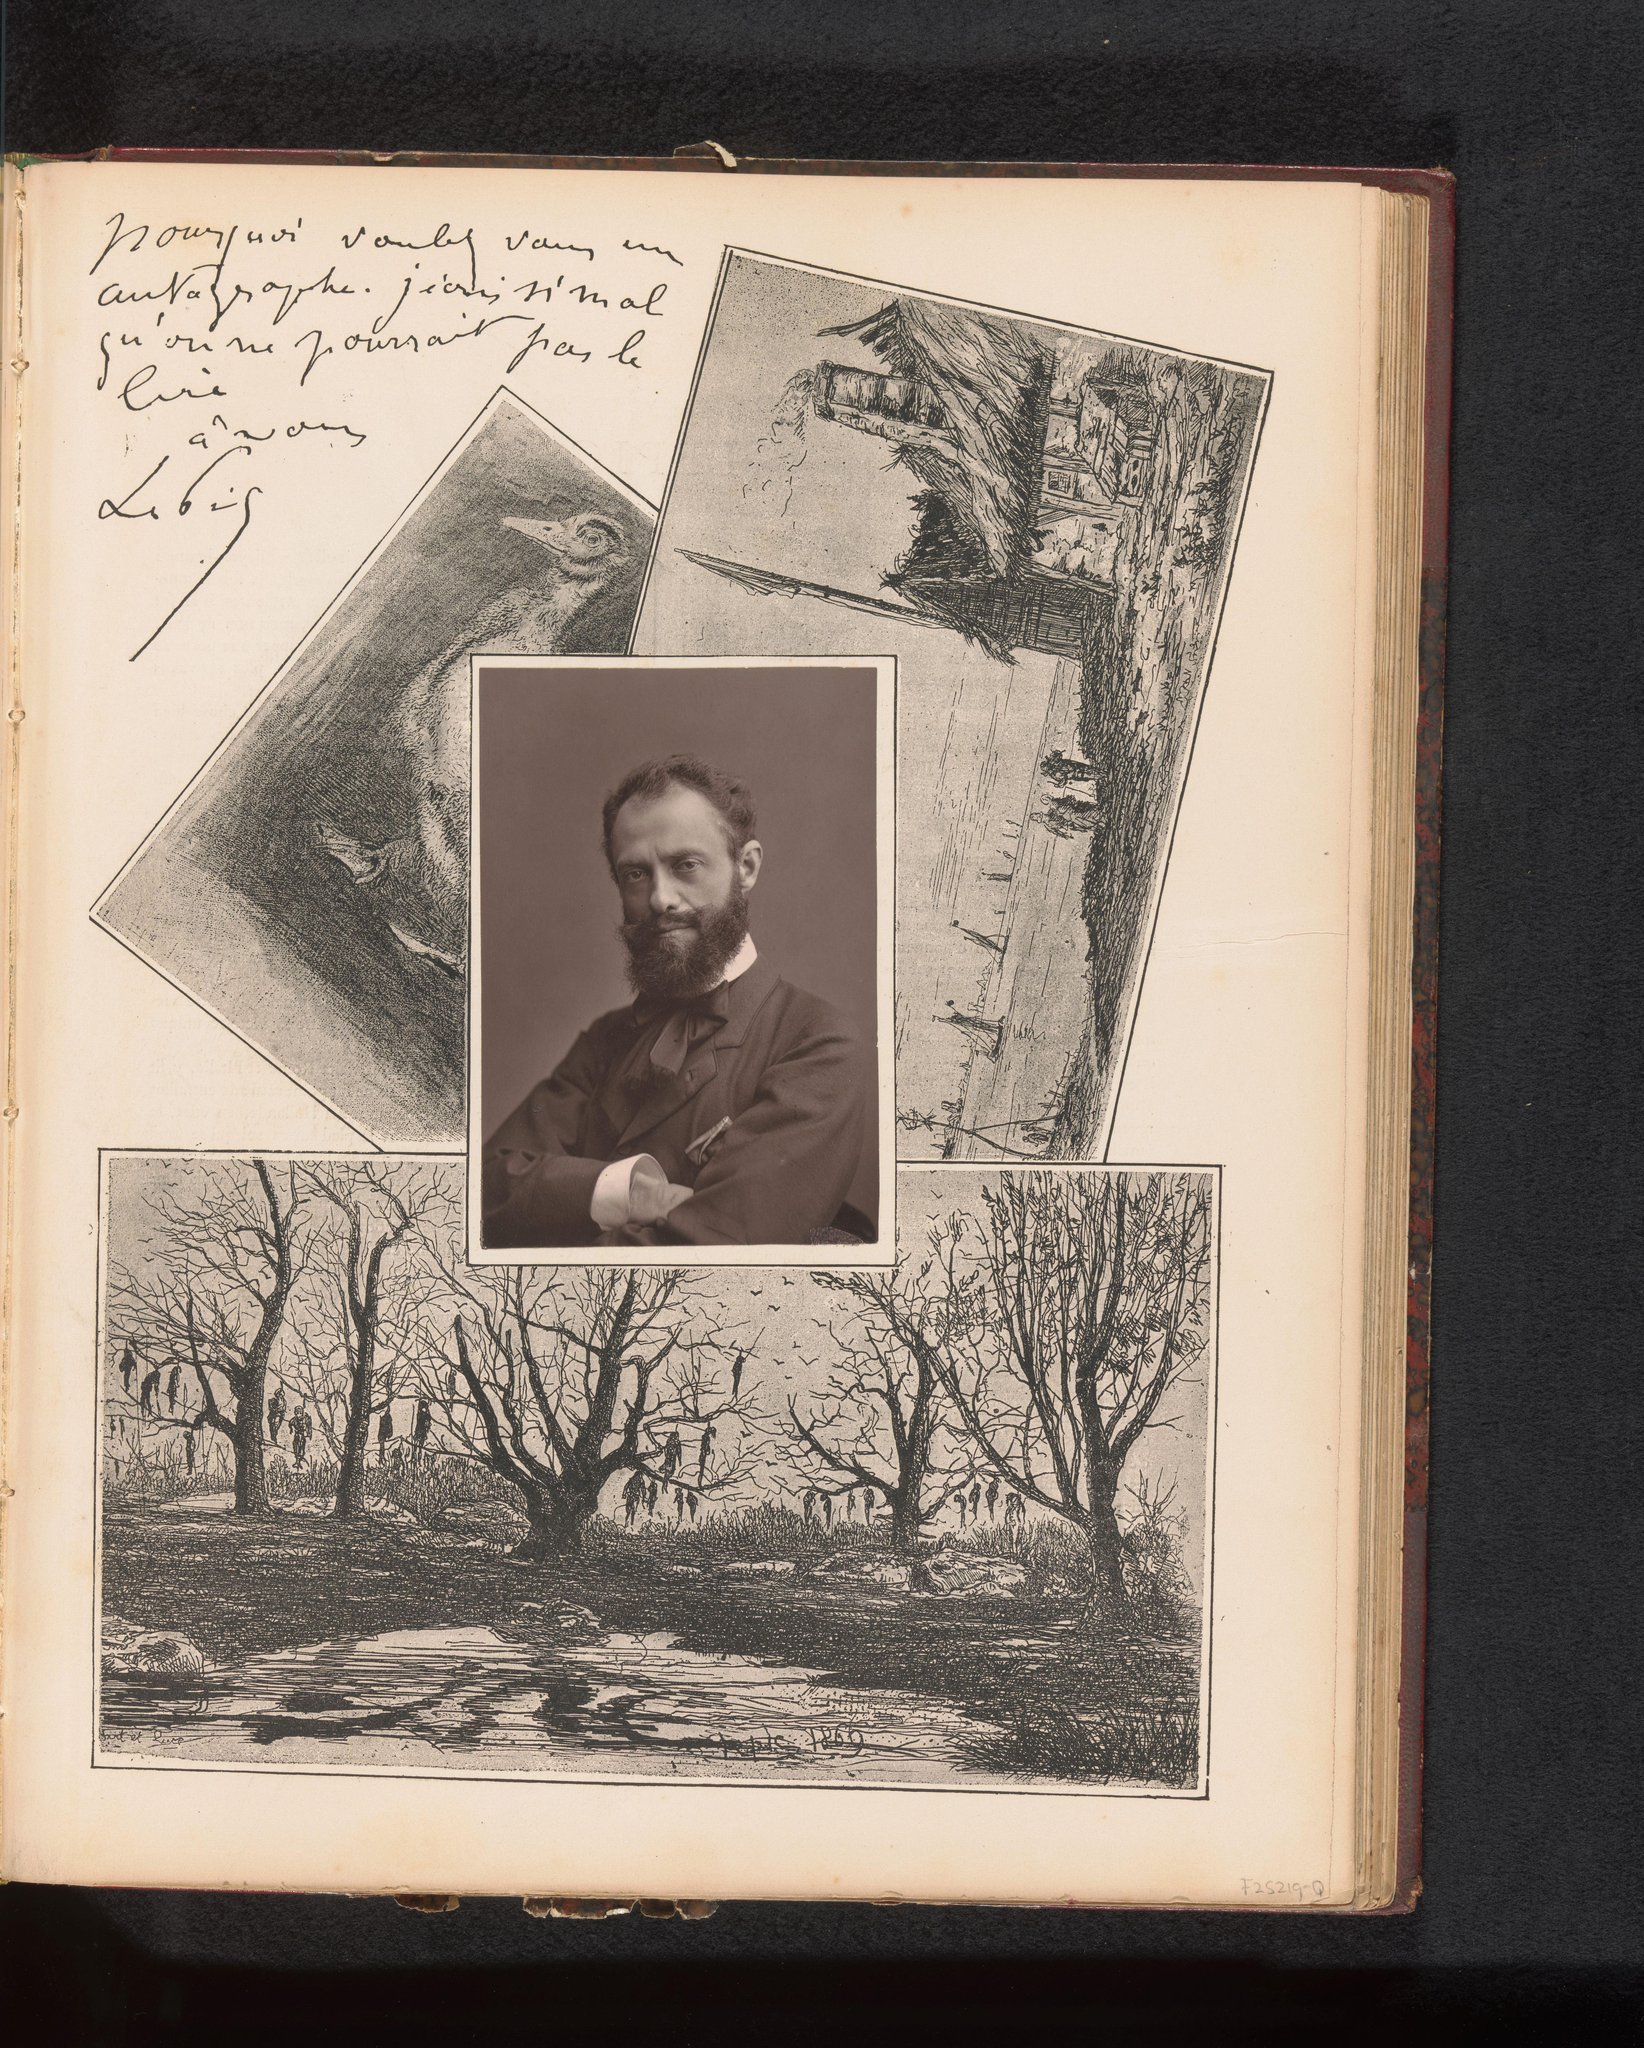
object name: photomechanical print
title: Portret van Ludovic Napoléon Lepic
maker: Anonymous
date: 1872-1877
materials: paper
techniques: woodburytype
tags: ludovic napoléon lepic, adult man, historical persons